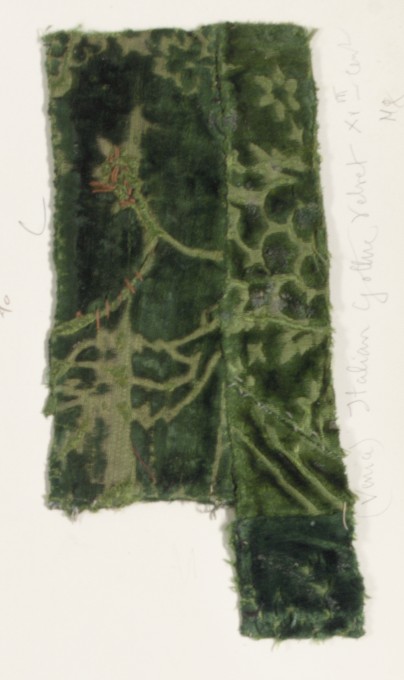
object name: fragment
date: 1501-1600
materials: silk